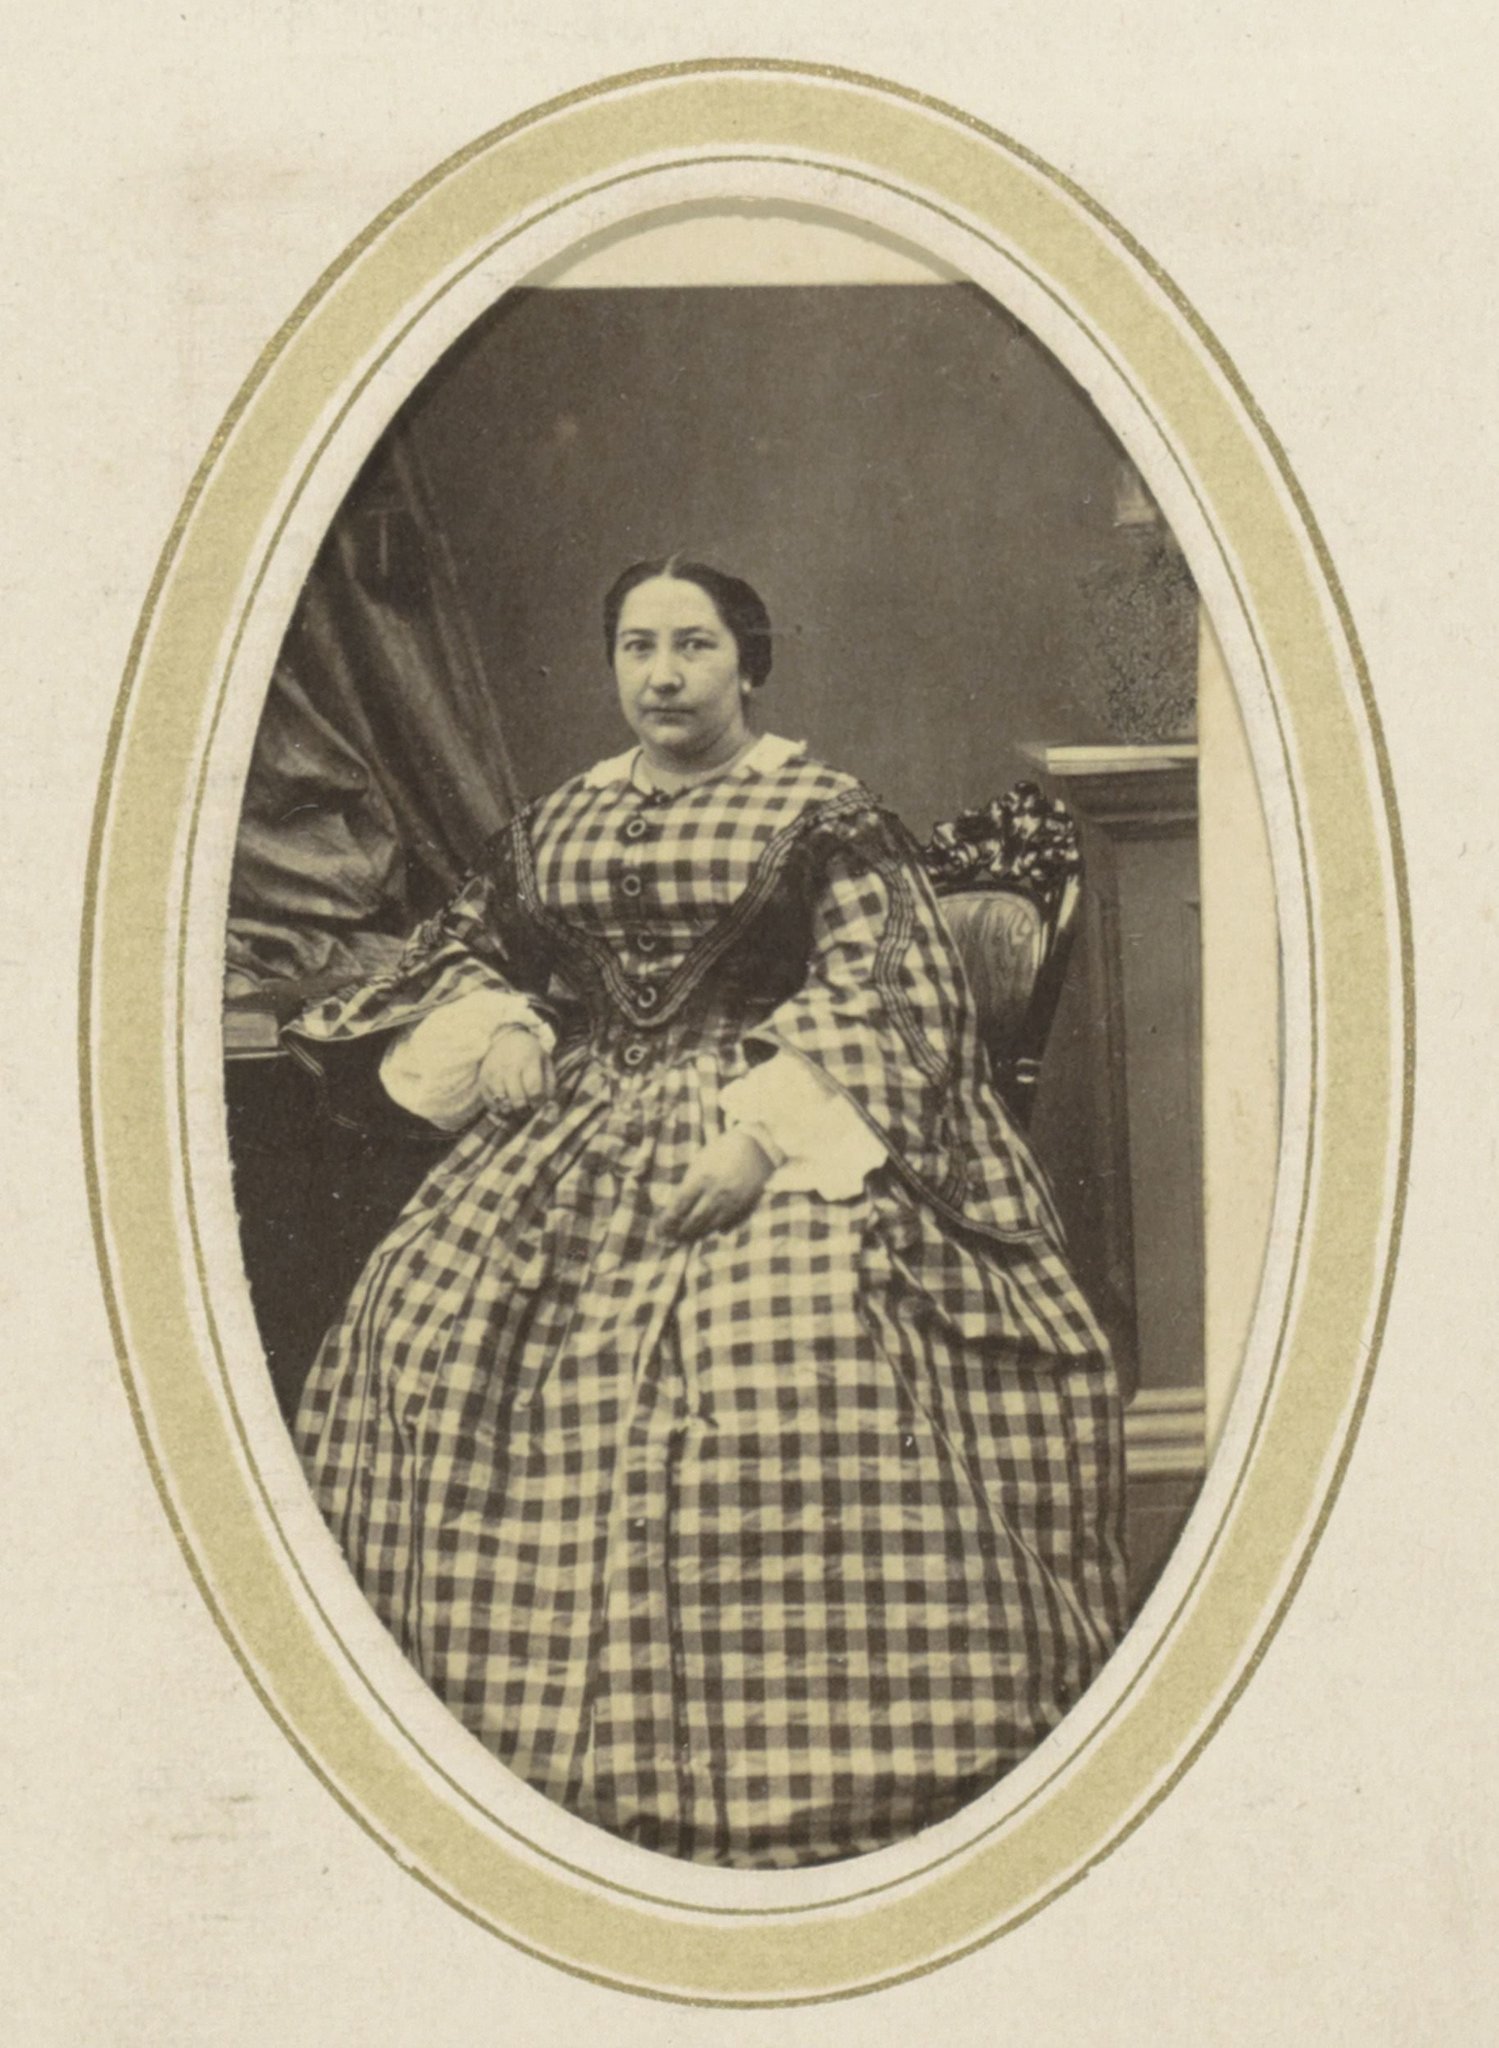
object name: carte de visite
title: Portret van een vrouw in een geruite jurk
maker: n. hense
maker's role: painter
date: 1862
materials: cardboard, paper, photographic support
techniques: albumen print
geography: zeist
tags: studio requisites ~ photographer, historical persons, clothing for the upper part of the body, hairdress, dress, gown, ear-rings, zeist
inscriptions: inscription: ‘1862’, stamp: ‘N. Hense te Ze[..]st’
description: Onderdeel van Fotoalbum van een Nederlandse familie met 168 cartes-de-visite en kabinetfoto's.